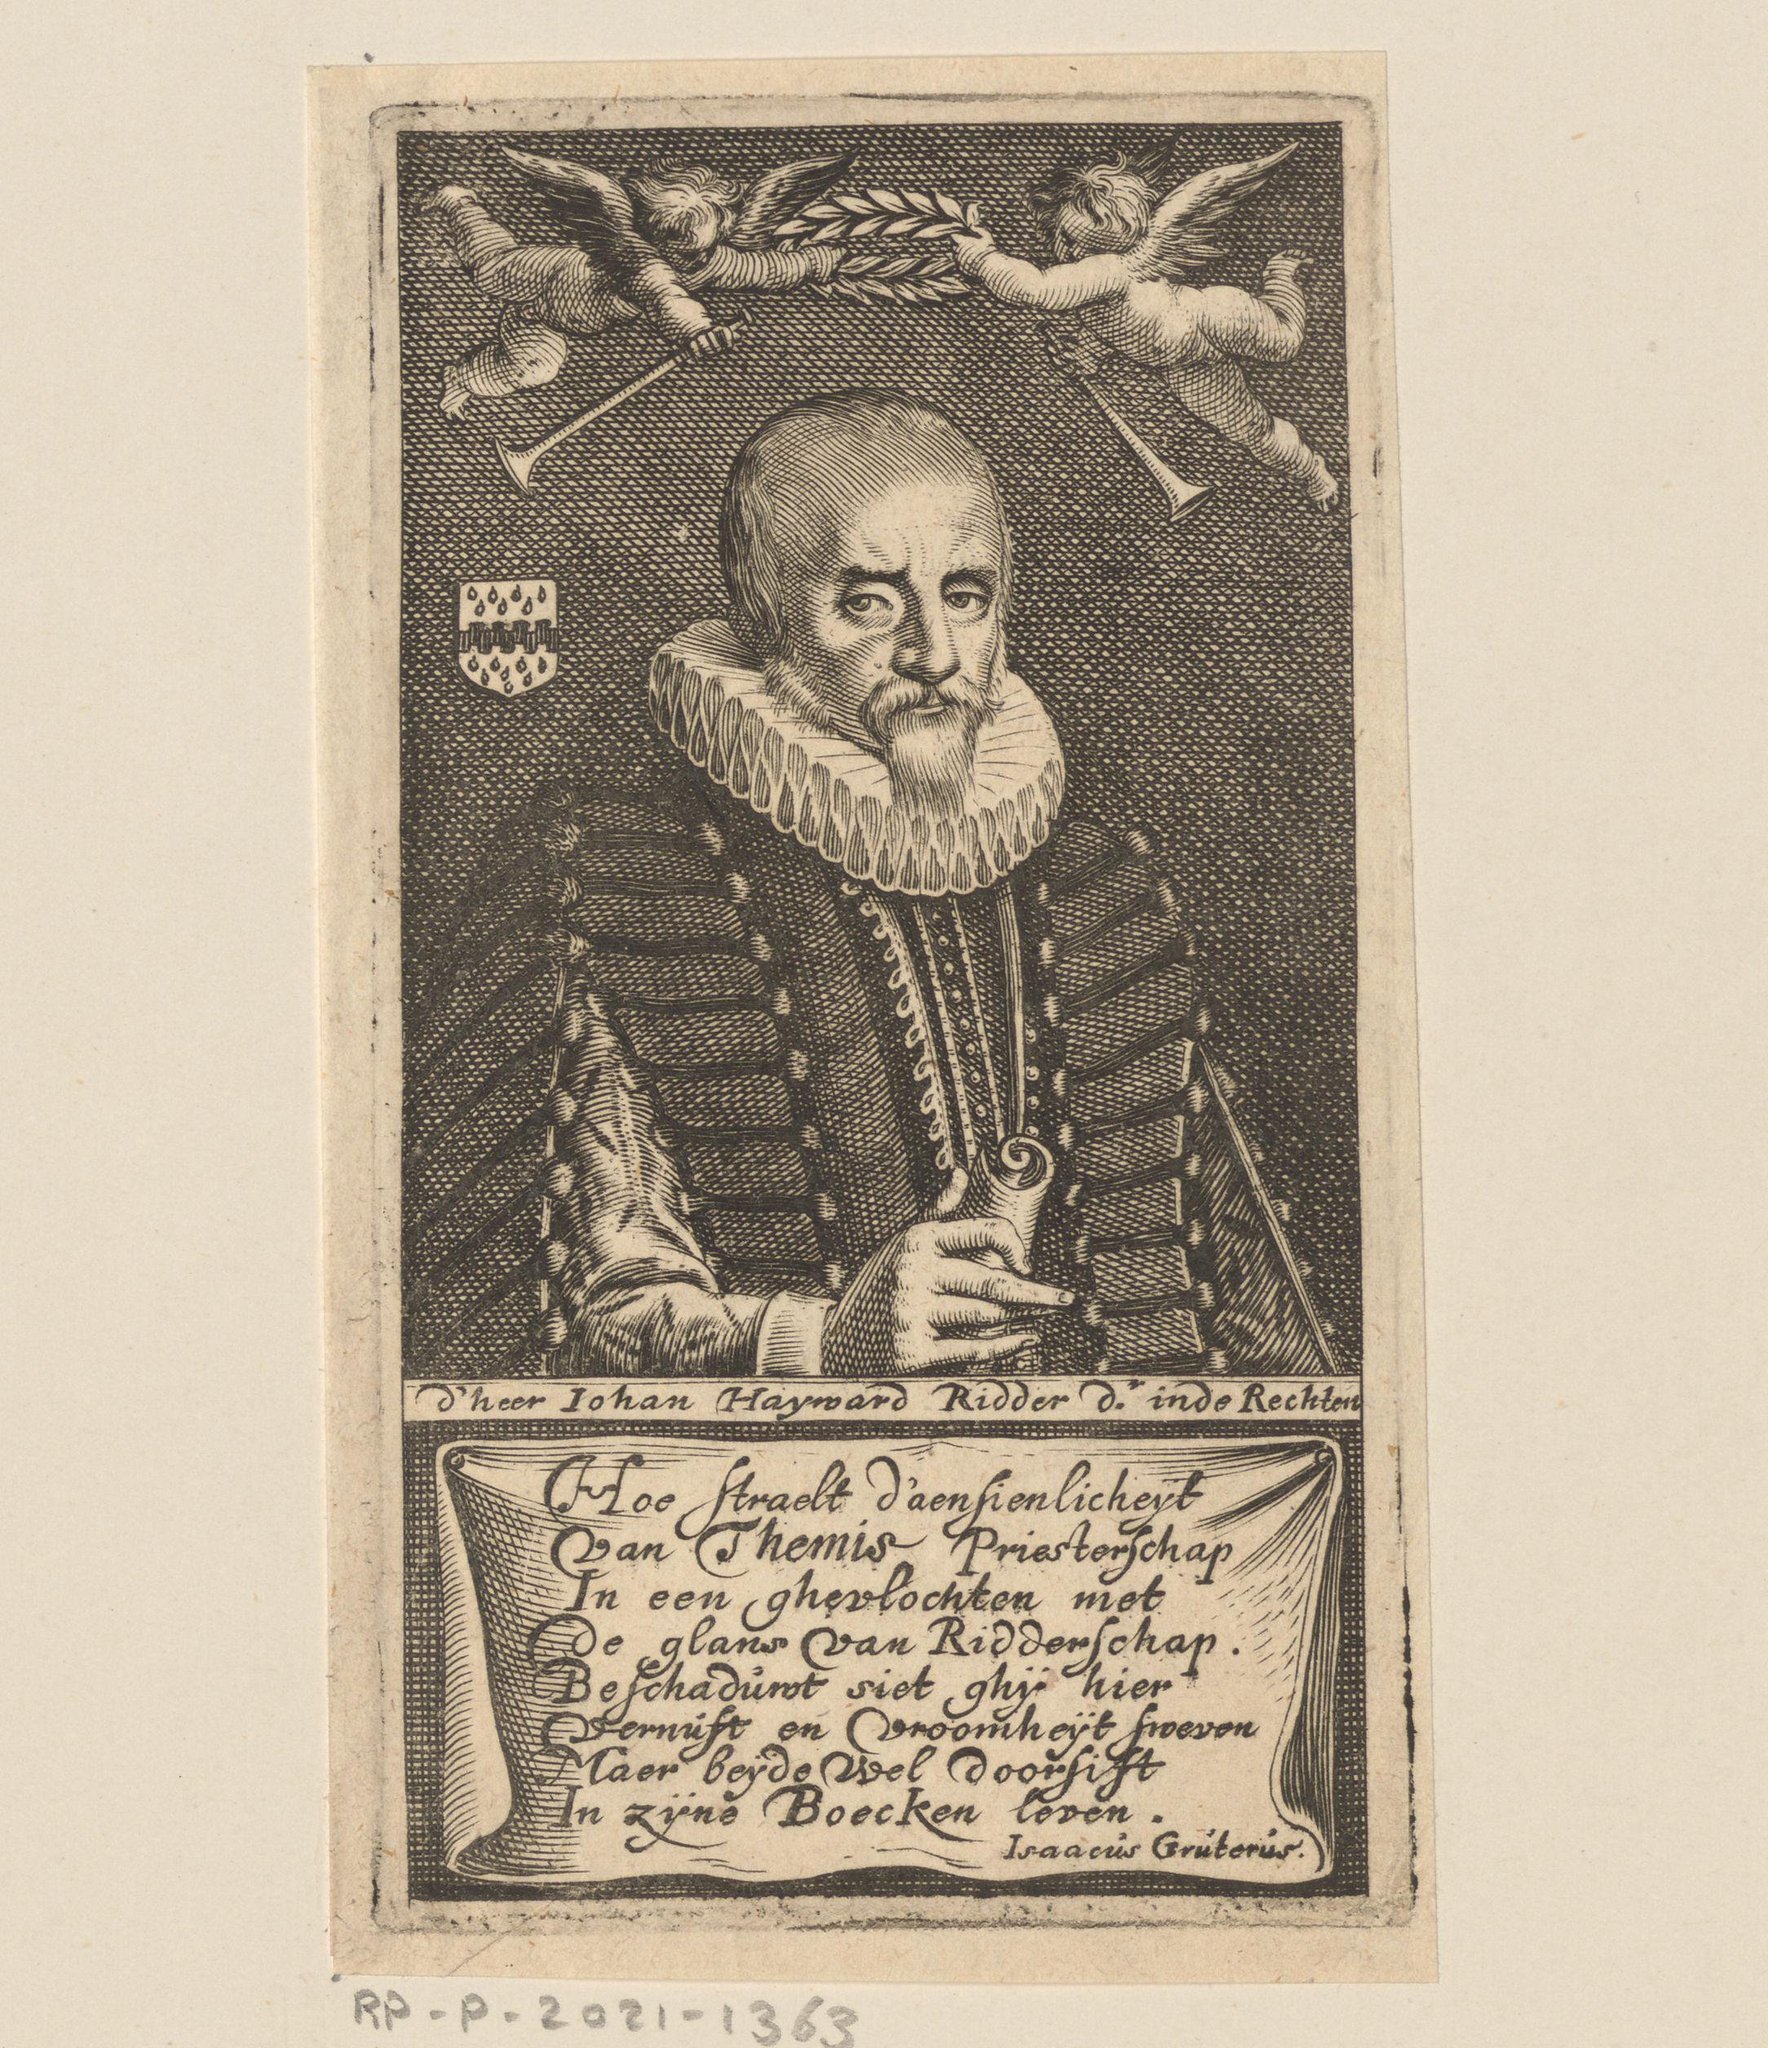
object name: print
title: Portret van John Hayward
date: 1650-1699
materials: paper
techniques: engraving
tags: honouring the artist with laurel wreath, historical persons, portrait of a writer, armorial bearing, heraldry